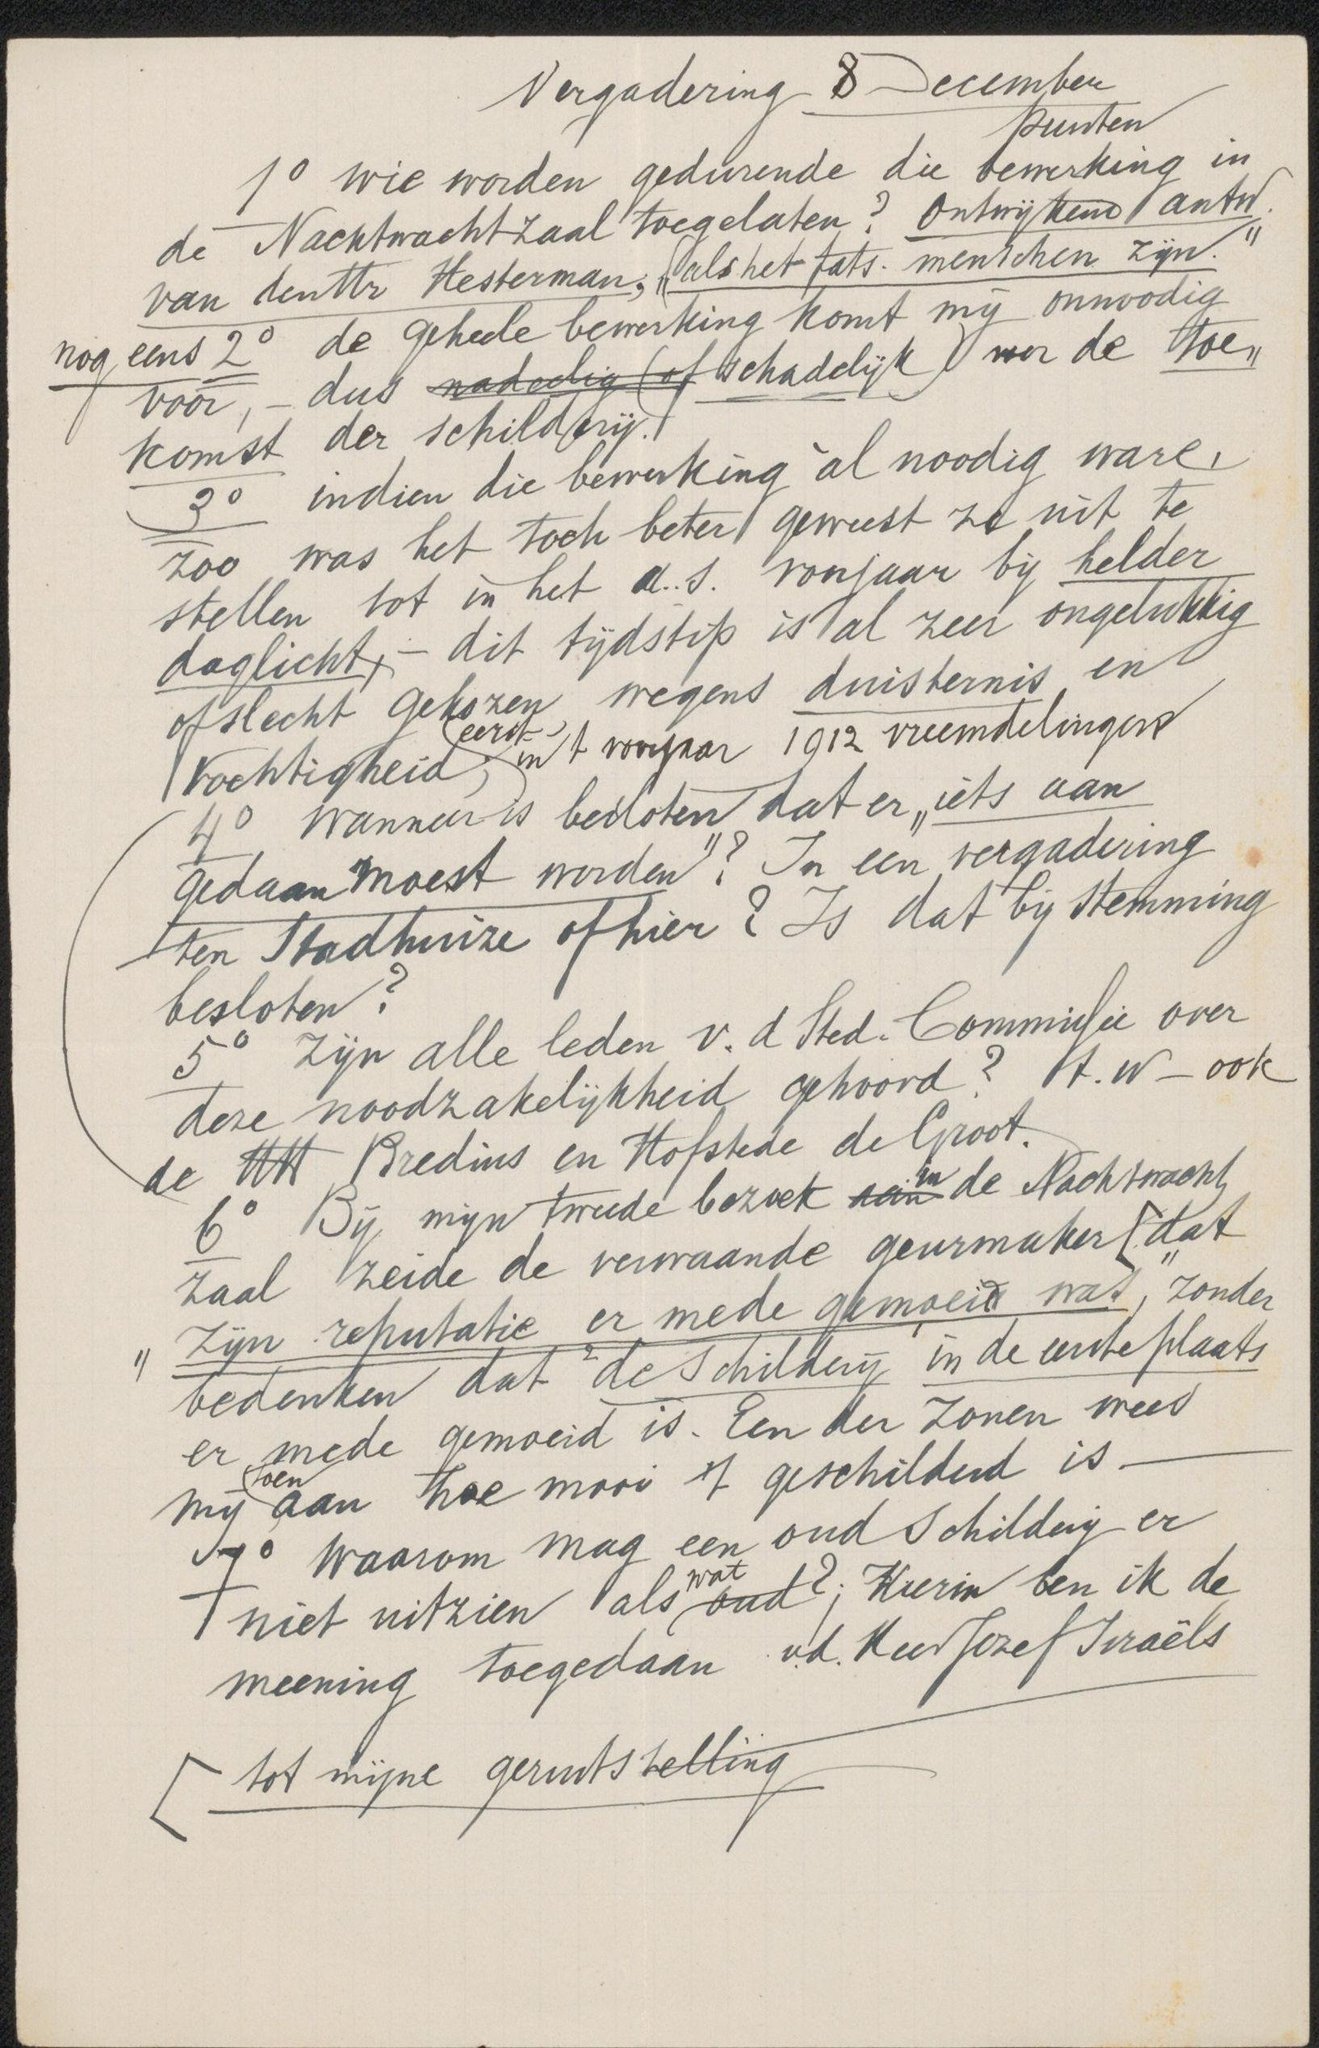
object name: aantekening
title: Aantekening uit collectie August Allebé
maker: august allebé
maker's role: draughtsman, print maker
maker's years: 1838-1927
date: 1848-1927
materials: ink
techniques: pen, writing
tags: conservator, the hague, painter, print maker, draughtsman, jozef israëls, cornelis hofstede de groot, painting (including book-illumination, miniature-painting)